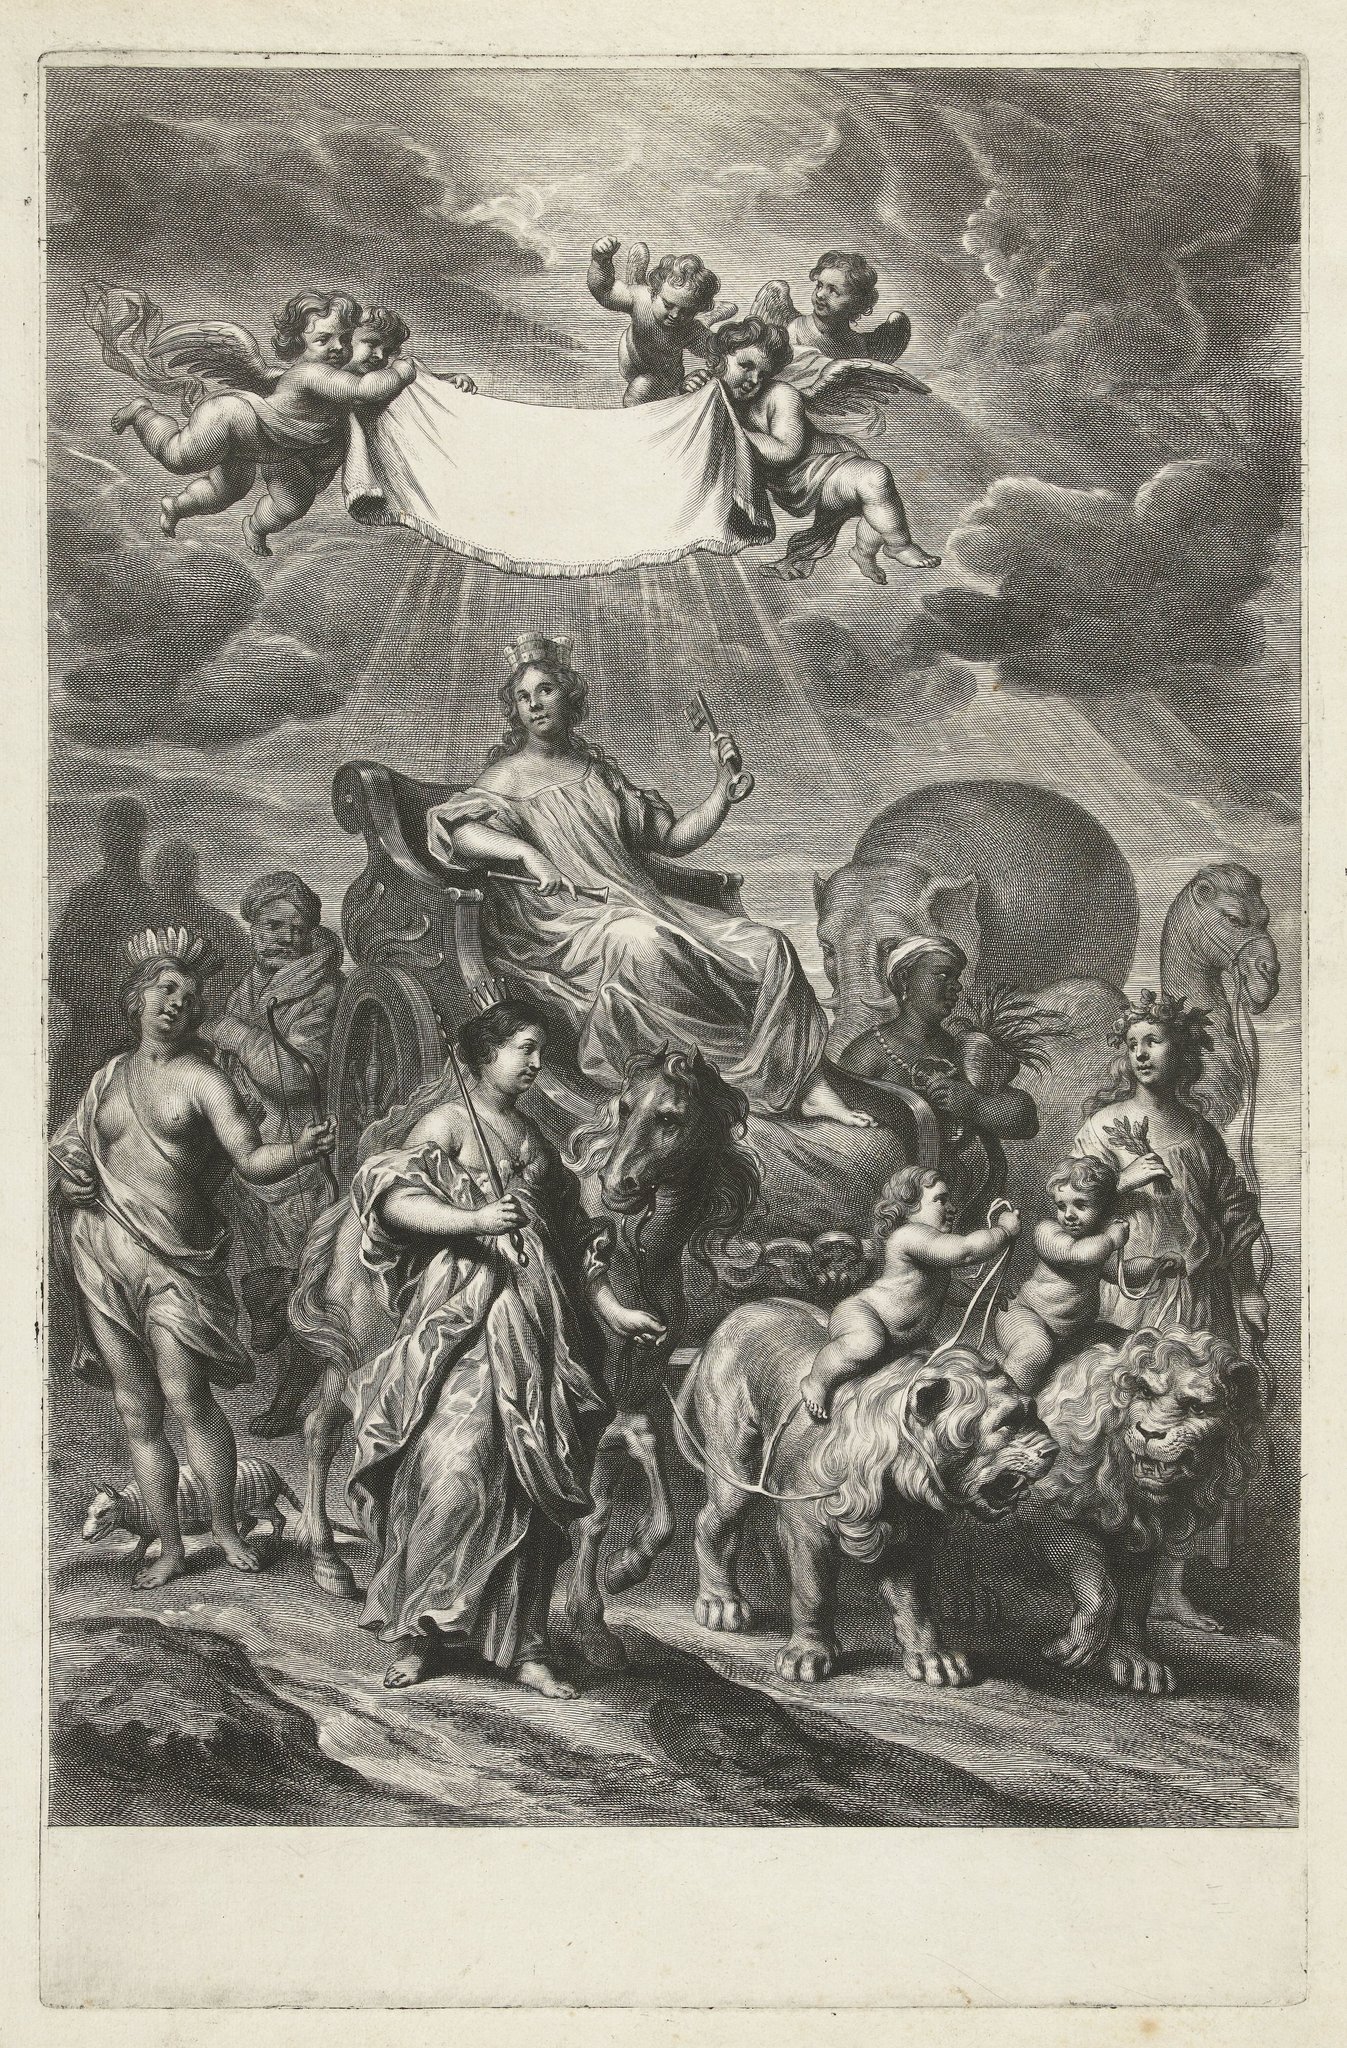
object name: print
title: Titelpagina voor: Joan Blaeu, Geographia, qvæ est Cosmographiæ Blavianæ pars prima, Amsterdam 1665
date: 1648-1664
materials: paper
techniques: engraving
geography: amsterdam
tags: 'geografia', europe represented allegorically; 'europa' (ripa), asia represented allegorically; 'asia' (ripa), africa represented allegorically; 'africa' (ripa), america represented allegorically; 'america' (ripa)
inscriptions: collector's mark: Lugt 240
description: Vrouwelijke personificatie van Geografie op triomfwagen getrokken door leeuwen. Personificaties van de werelddelen Amerika, Afrika, Azië en Europa met hun attributen, zoals dromedaris en olifant, lopen mee. Opmerkelijk is het attribuut van Amerika, bij haar voeten loopt een gordeldier in plaats van de meer gebruikelijke krokodil of kaaiman. Kleine engelen in de lucht houden een doek vast waarop op een latere staat de titel van de uitgave verschijnt.